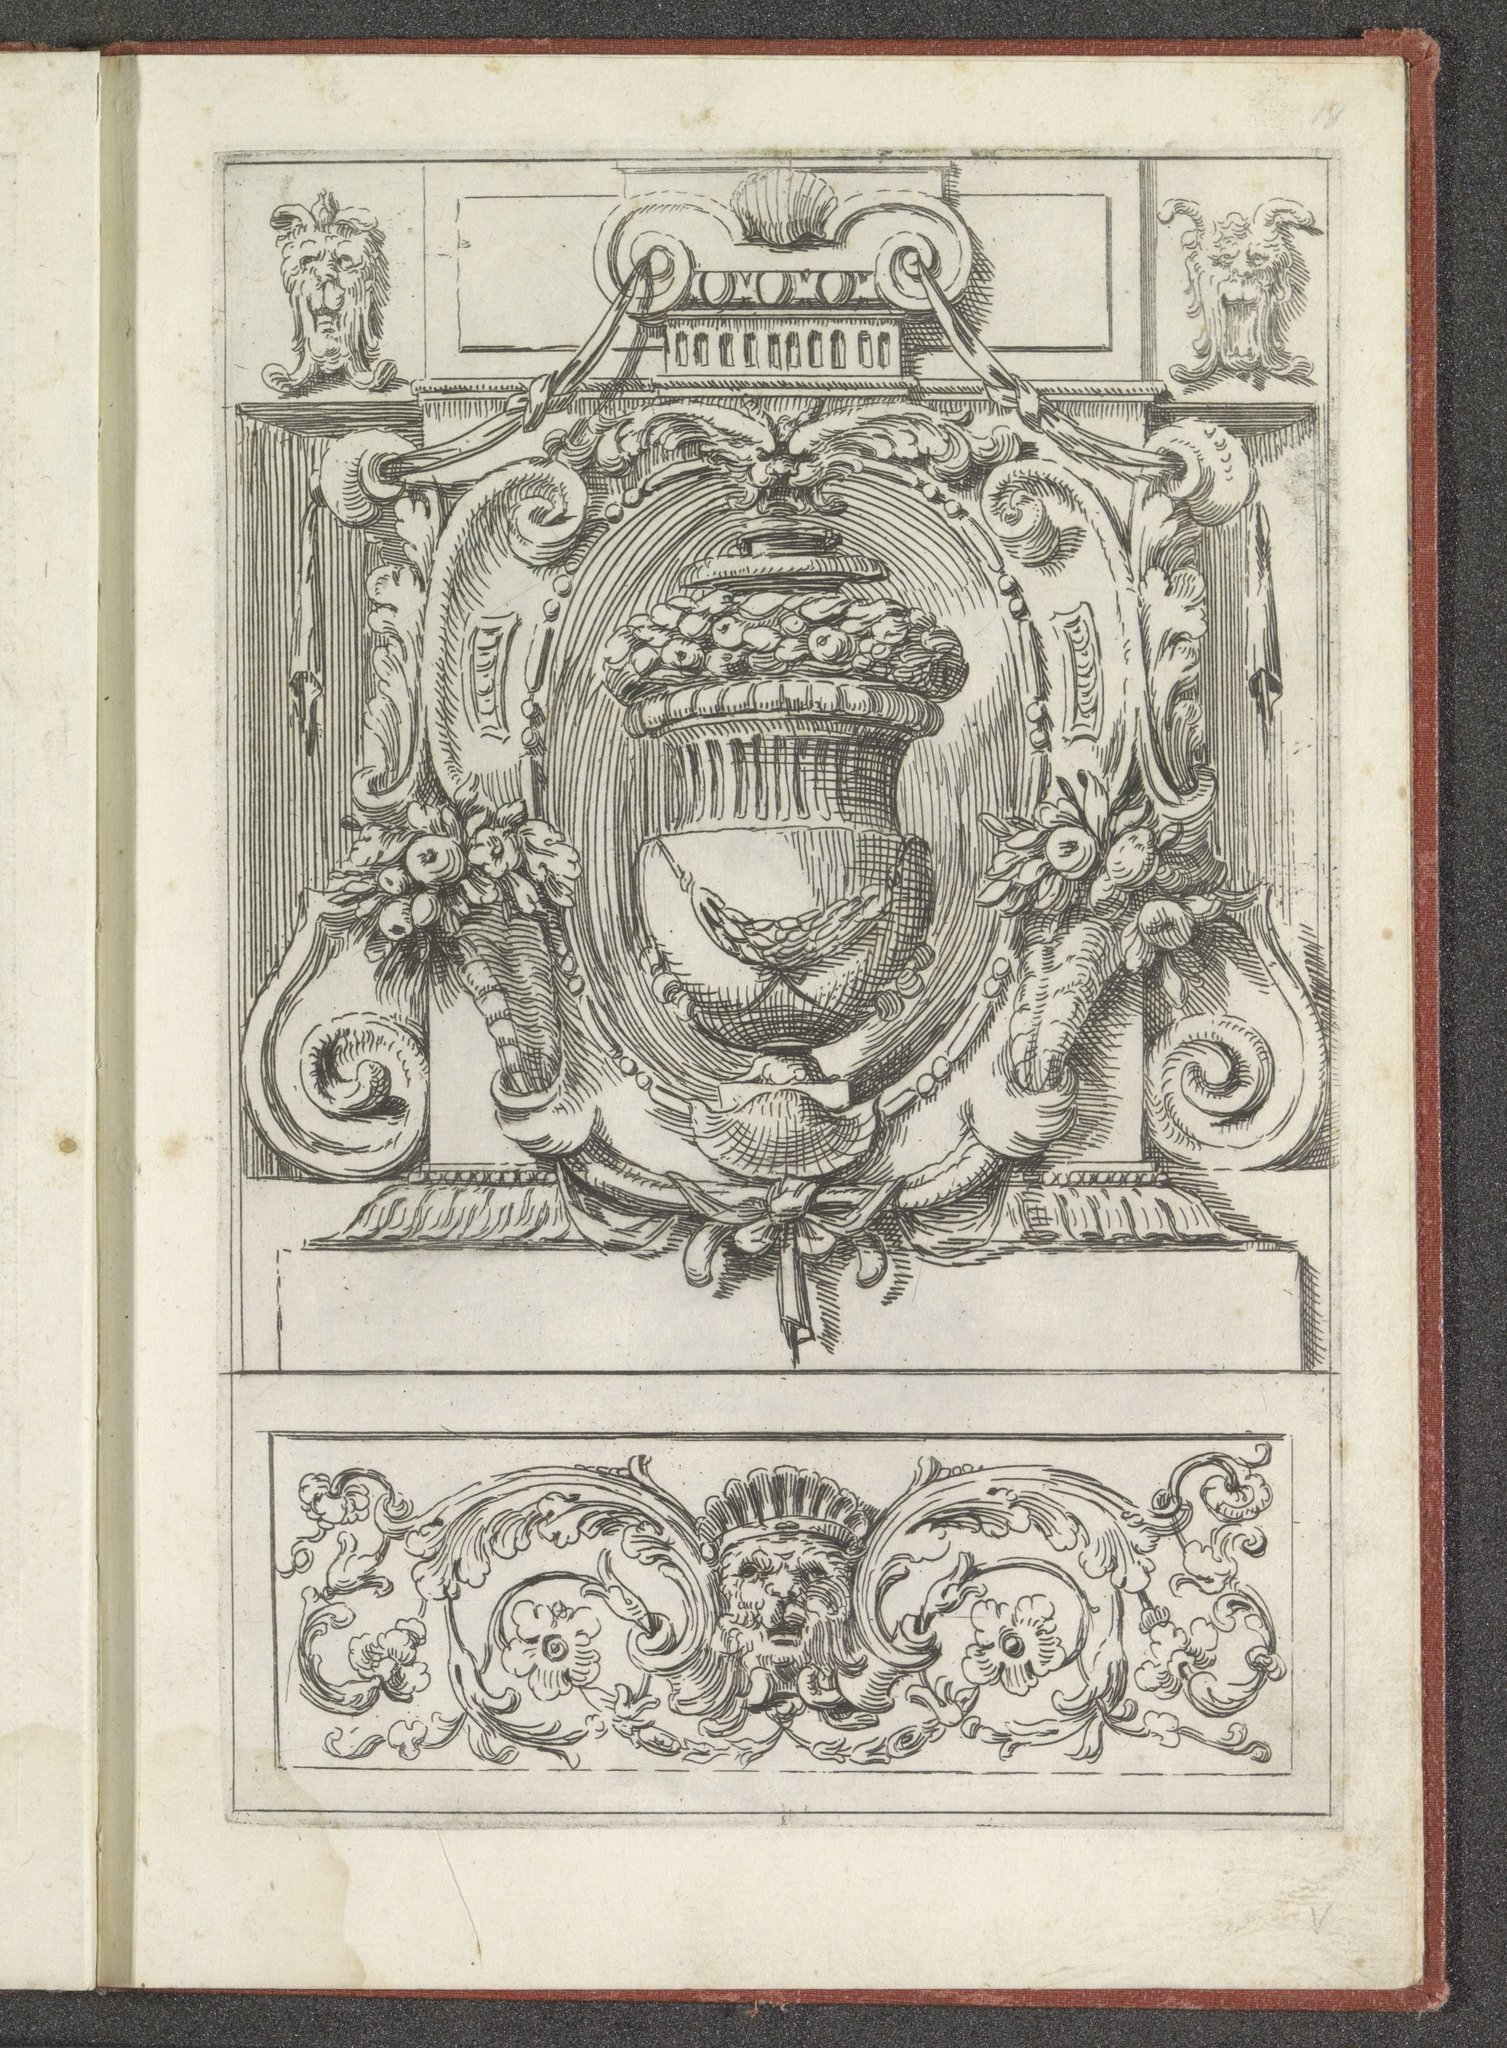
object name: print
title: Cartouches par Mitelli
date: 1636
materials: paper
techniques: etching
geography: bologna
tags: rocaille ornament, foliage ~ ornament, vase ~ ornament, ornament ~ cartouche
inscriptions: collector's mark: Lugt 2228, collector's mark: Lugt 2760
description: Boven een monument met een cartouche met daarin een vaas met vruchten. Onder een fries met een ornamentkop tussen rocailles. De prent maakt deel uit van een album.